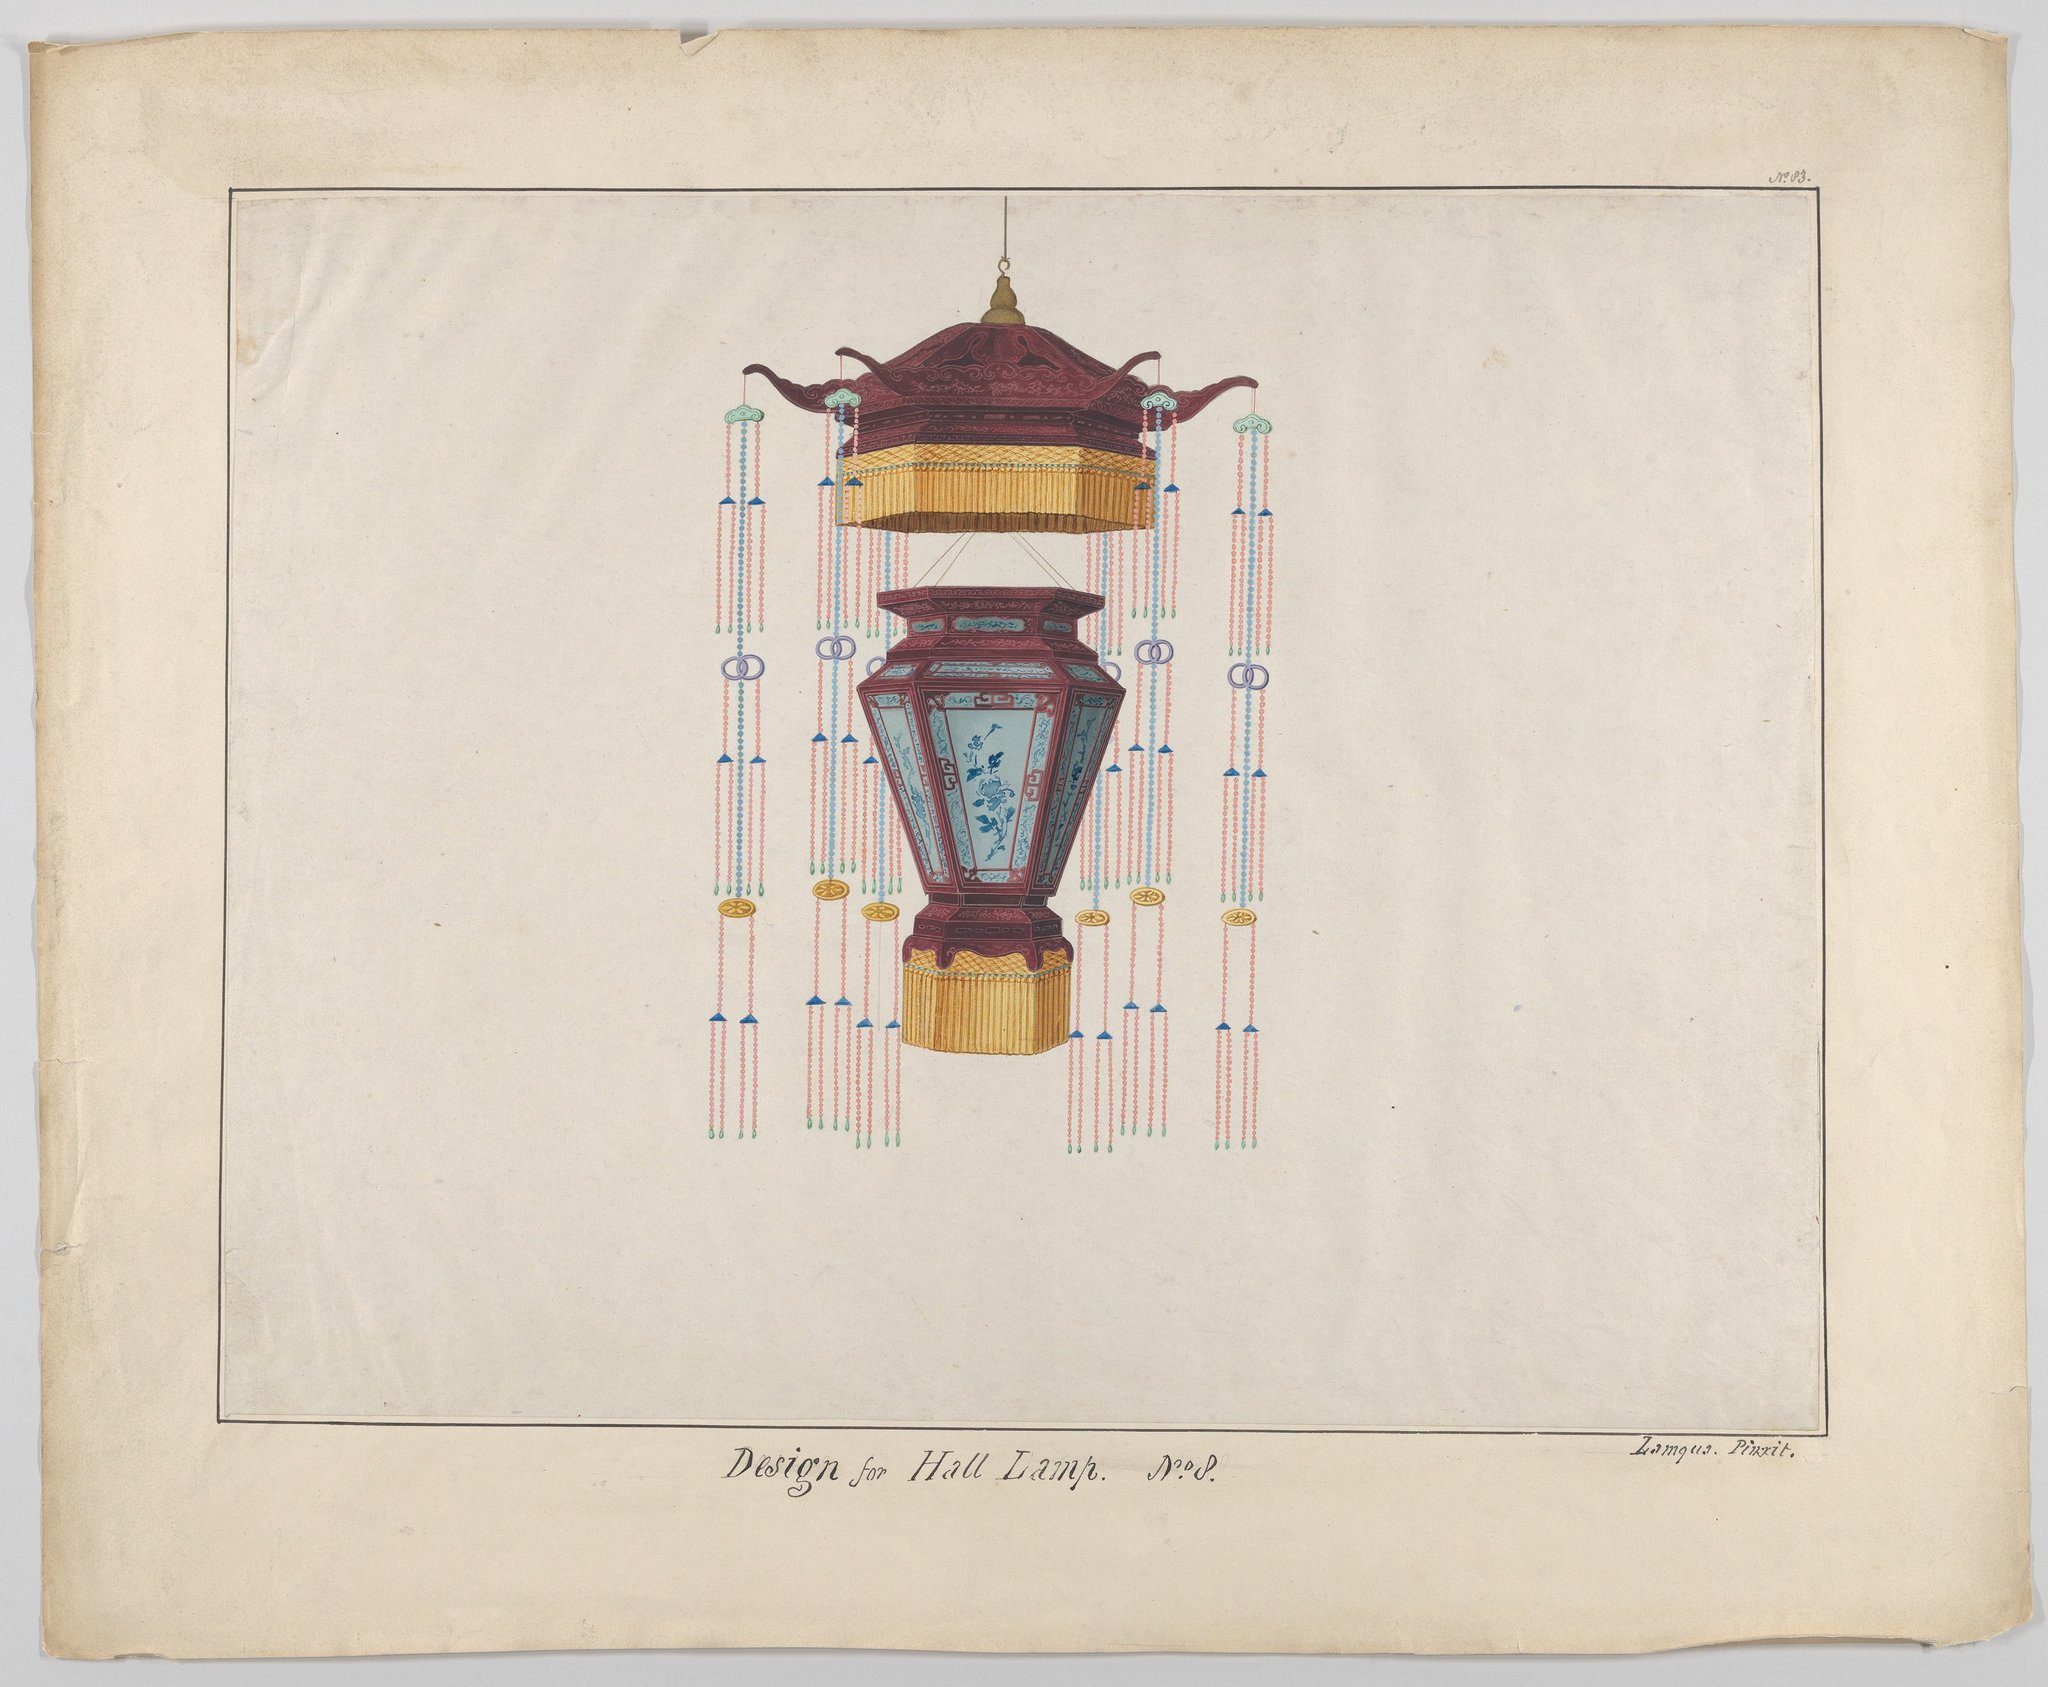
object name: drawing ornament architecture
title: Design for a Hall Lamp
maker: lamqua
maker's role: artist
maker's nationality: chinese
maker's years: 1800-1900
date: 1800-1810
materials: gouache, watercolor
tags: lamps